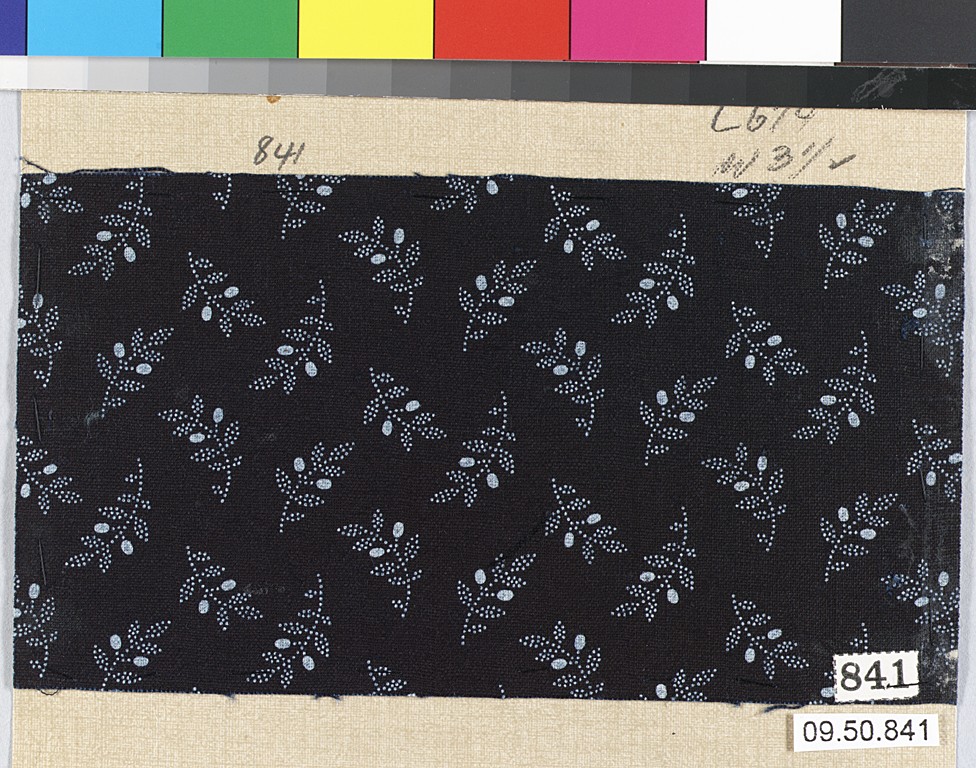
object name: piece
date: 1801-1900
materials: cotton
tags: leaves